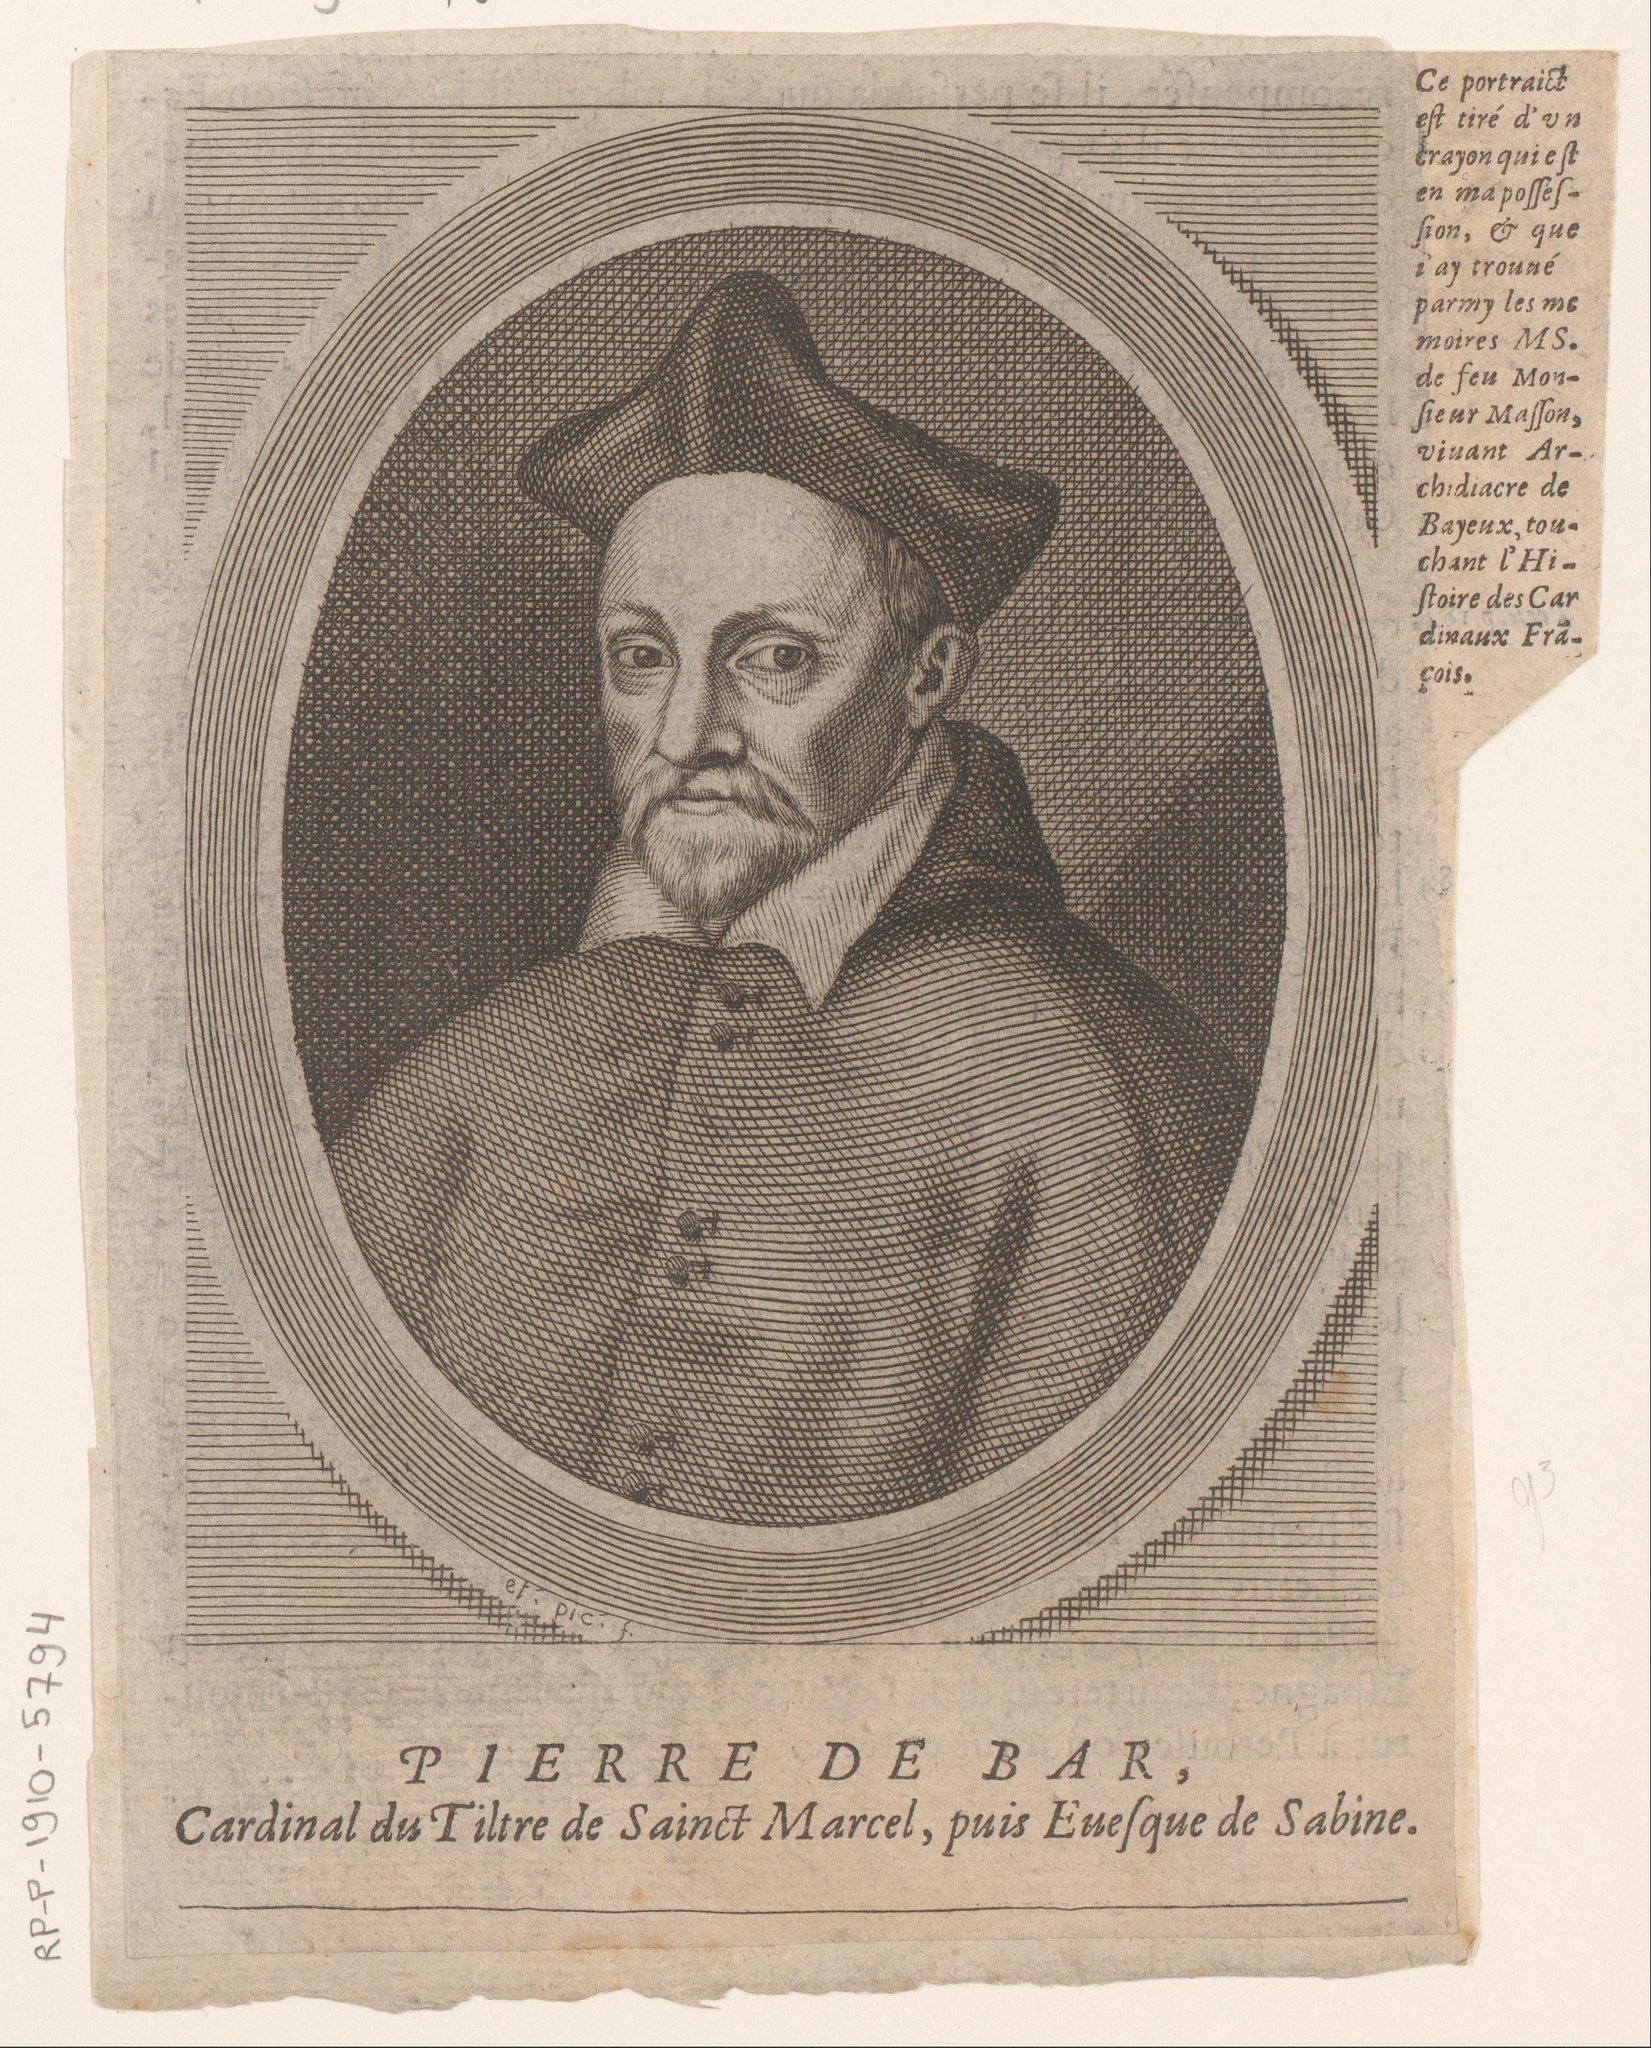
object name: book illustration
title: Pierre de Bar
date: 1660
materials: paper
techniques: engraving, etching, letterpress printing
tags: archbishop, bishop, etc. (roman catholic), historical persons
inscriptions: collector's mark: Lugt 2228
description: Prent uit: Du Chesne, François. Histoire de tous les cardinaux françois de naissance, ou qui ont esté promeus au cardinalat. Parijs: François Du Chesne, 1660.